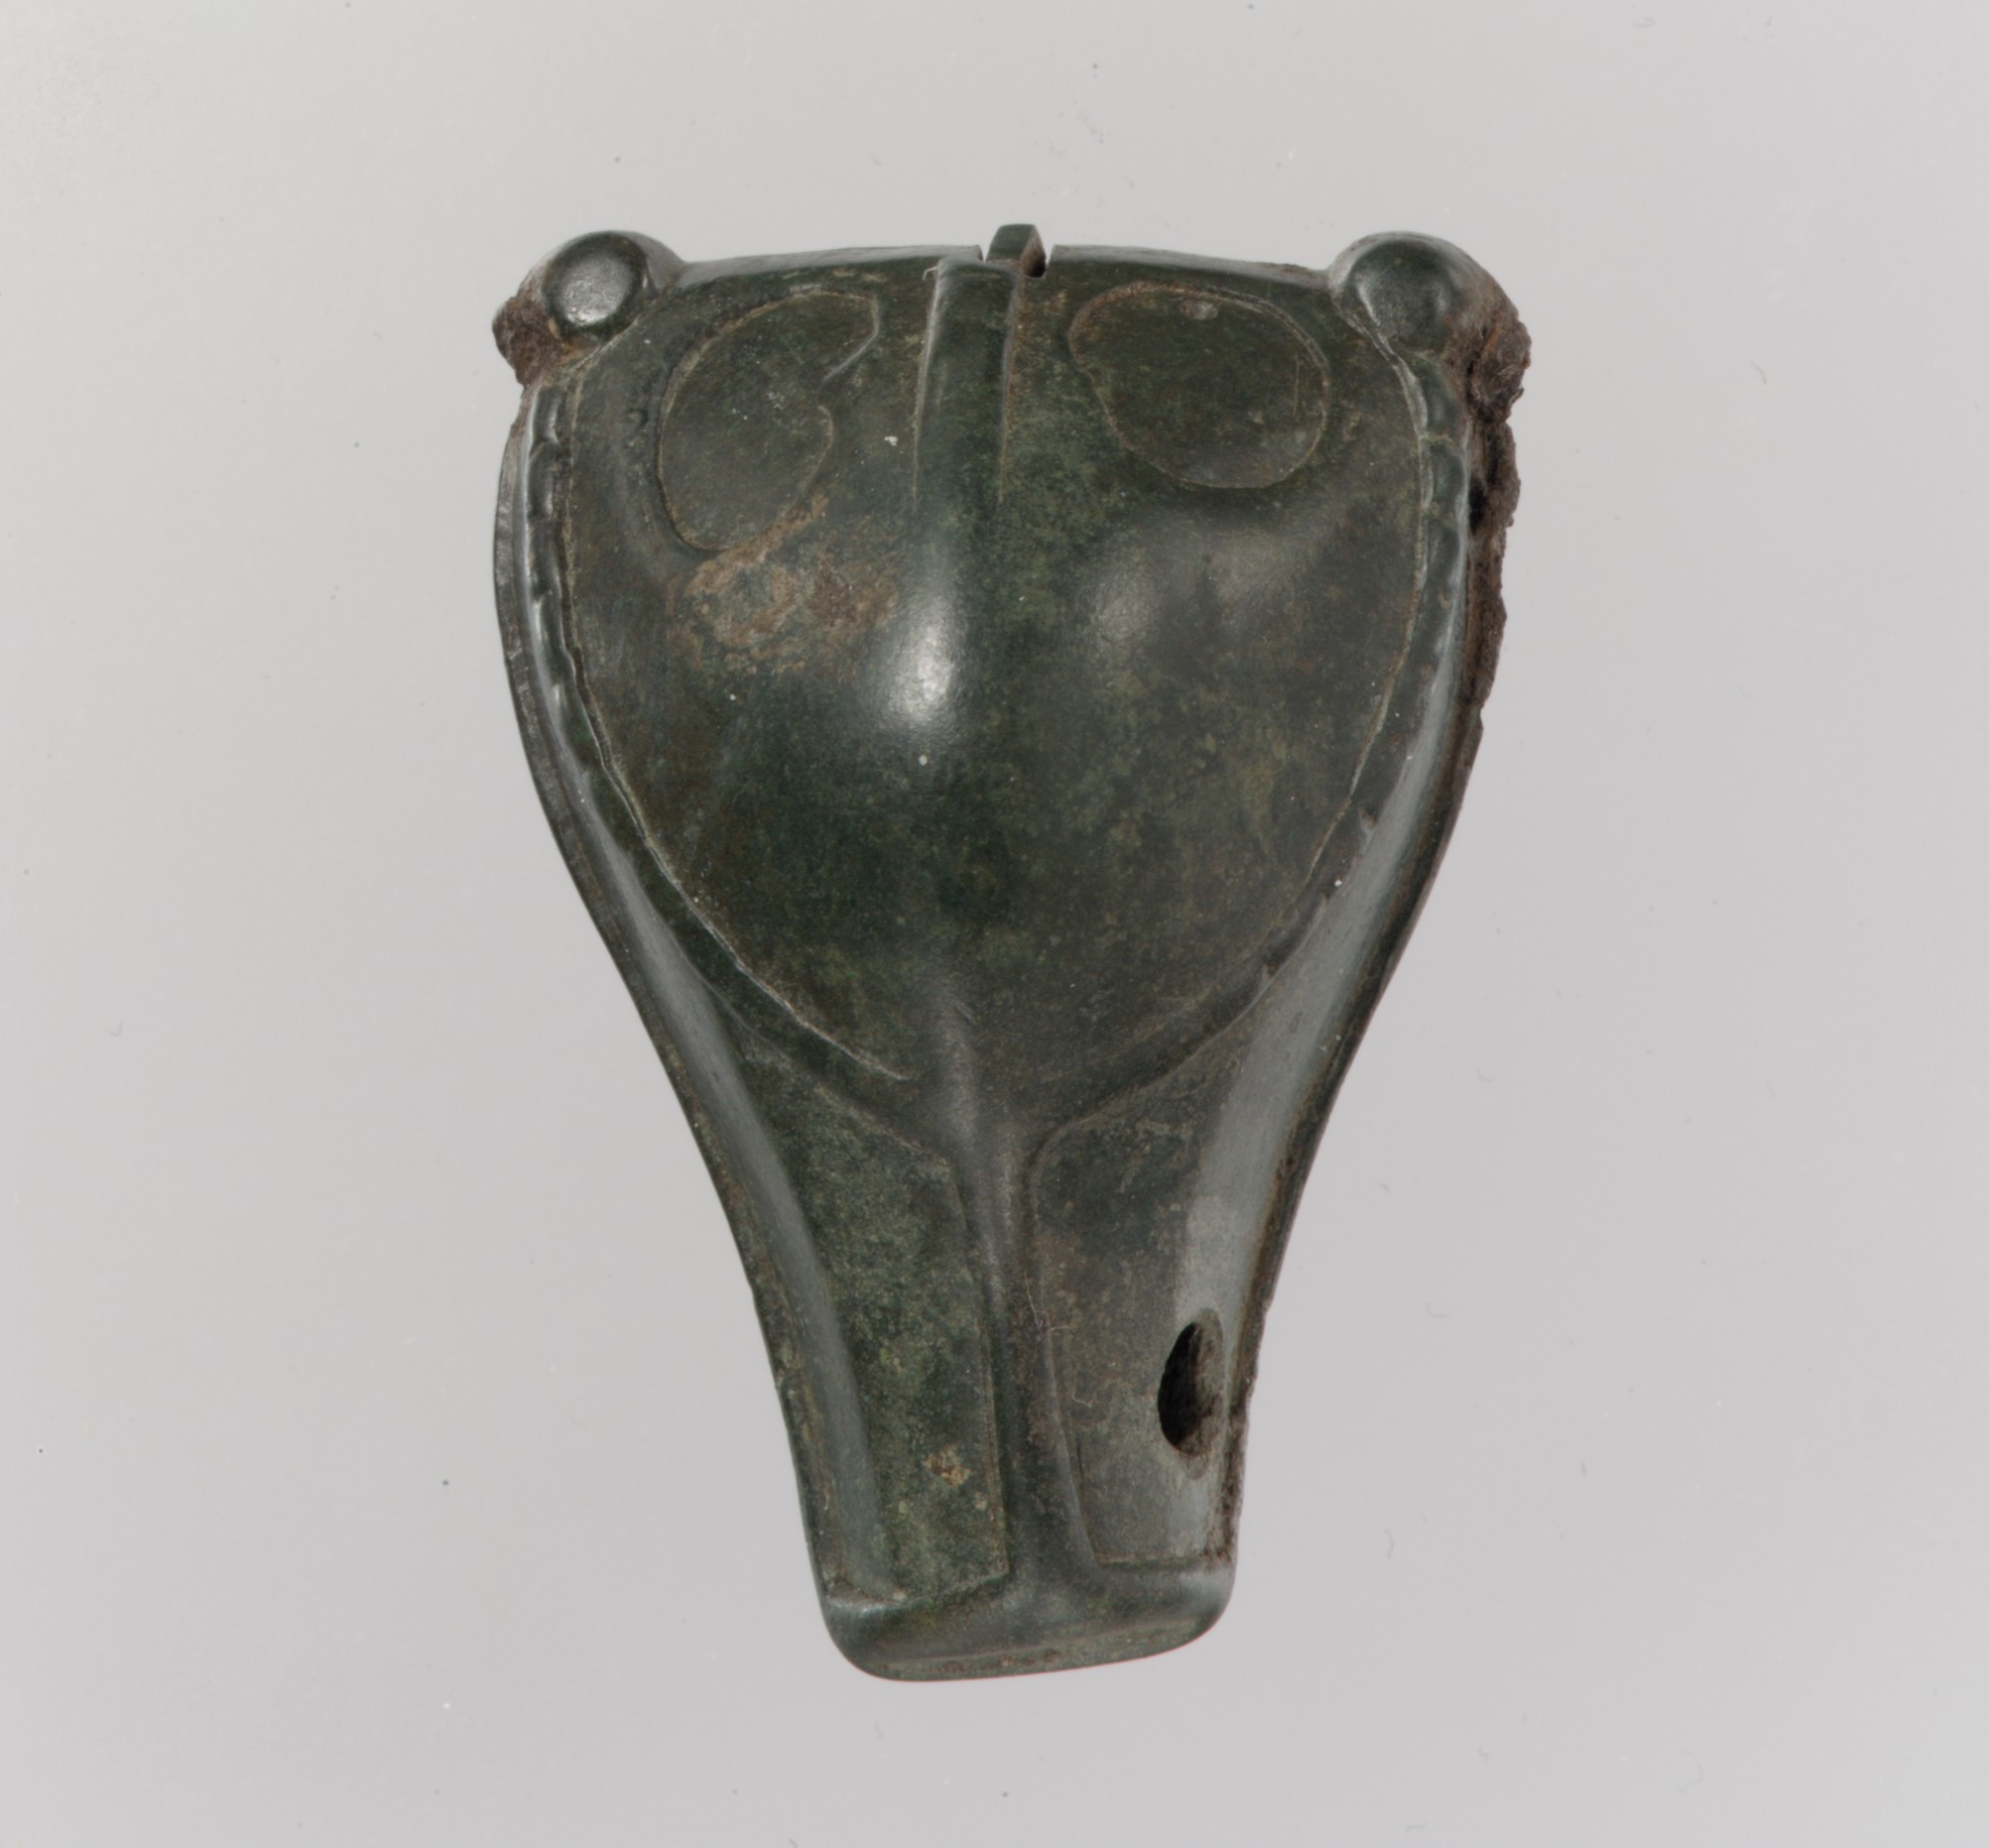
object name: brooch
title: Brooch with Boar’s-Head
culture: vendel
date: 767-800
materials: copper alloy, gilt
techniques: casting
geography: sweden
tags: boars